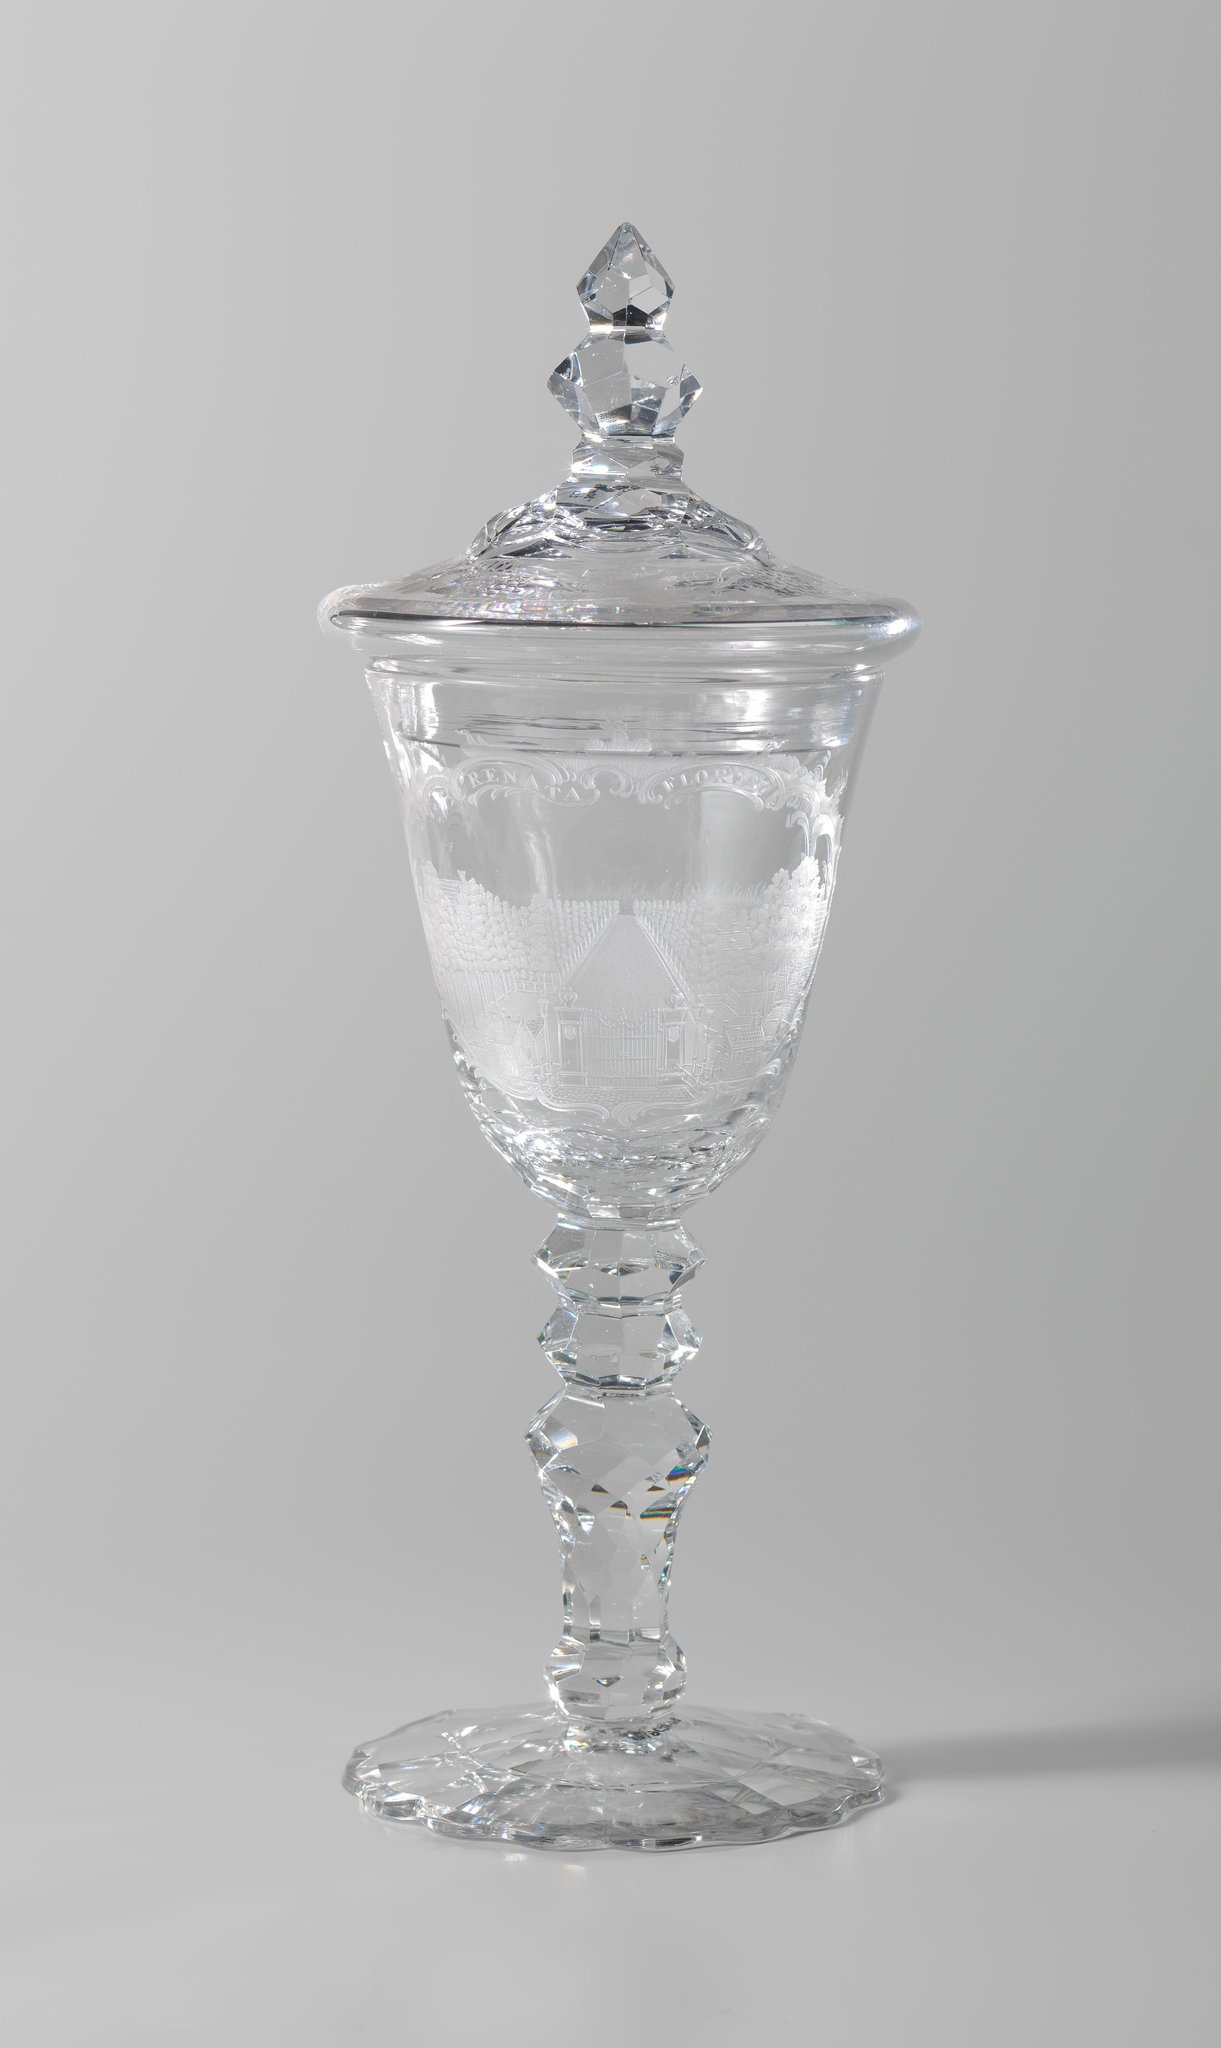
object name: goblet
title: Bokaal met de Middelweg (de huidige Middenweg) te Diemen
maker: simon jacob sang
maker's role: glasgraveur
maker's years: 1720-1786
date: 1768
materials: glass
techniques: glassblowing, grinding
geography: amsterdam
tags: amsterdam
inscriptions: inscription: ‘RENATA FLOREAT EX UNDIS’, signature and date: ‘Jacob Sang, // Fec: Amsterdam // 1768’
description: Facetgeslepen, conische voet met geschulpte rand. Facetgeslepen balustervormige stam met drie knopen. Trechtervormige kelk met facetgeslepen, afgeronde onderzijde. Gewelfd, geprofileerd deksel met een puntige knop samengesteld uit twee facetgeslepen knopen. Op de kelk, in een cartouche van voluten en schuimkragen, is een gezicht op de Middelweg (de huidige Middenweg) te Diemen weergegeven, gezien vanaf de kruising van de Ringdijk en de Outewalerbrug. Op de kruising, aan het begin van de weg, staat een tolhek met het wapen van de stad Amsterdam op de linker pijler en een onleesbare tekst op de rechter. Beide pijlers worden bekroond door een lantaarn en staan naast een wachthuis. Achter het hek is een rechthoekig plein met het Rechthuis aan de rechterzijde en een rij huizen aan de linkerzijde. Aan beide zijden van de weg staat een rij bomen. Boven de voorstelling, binnen de cartouche, staat de tekst: RENATA FLOREAT. Op de keerzijde een vergelijkbare cartouche met daarin een voorstelling van een meer omgeven door een rietkraag. Hierboven de tekst: EX UNDIS. Het glas is gesigneerd op de onderzijde van de voet: Jacob Sang, // Fec: Amsterdam // 1768,.